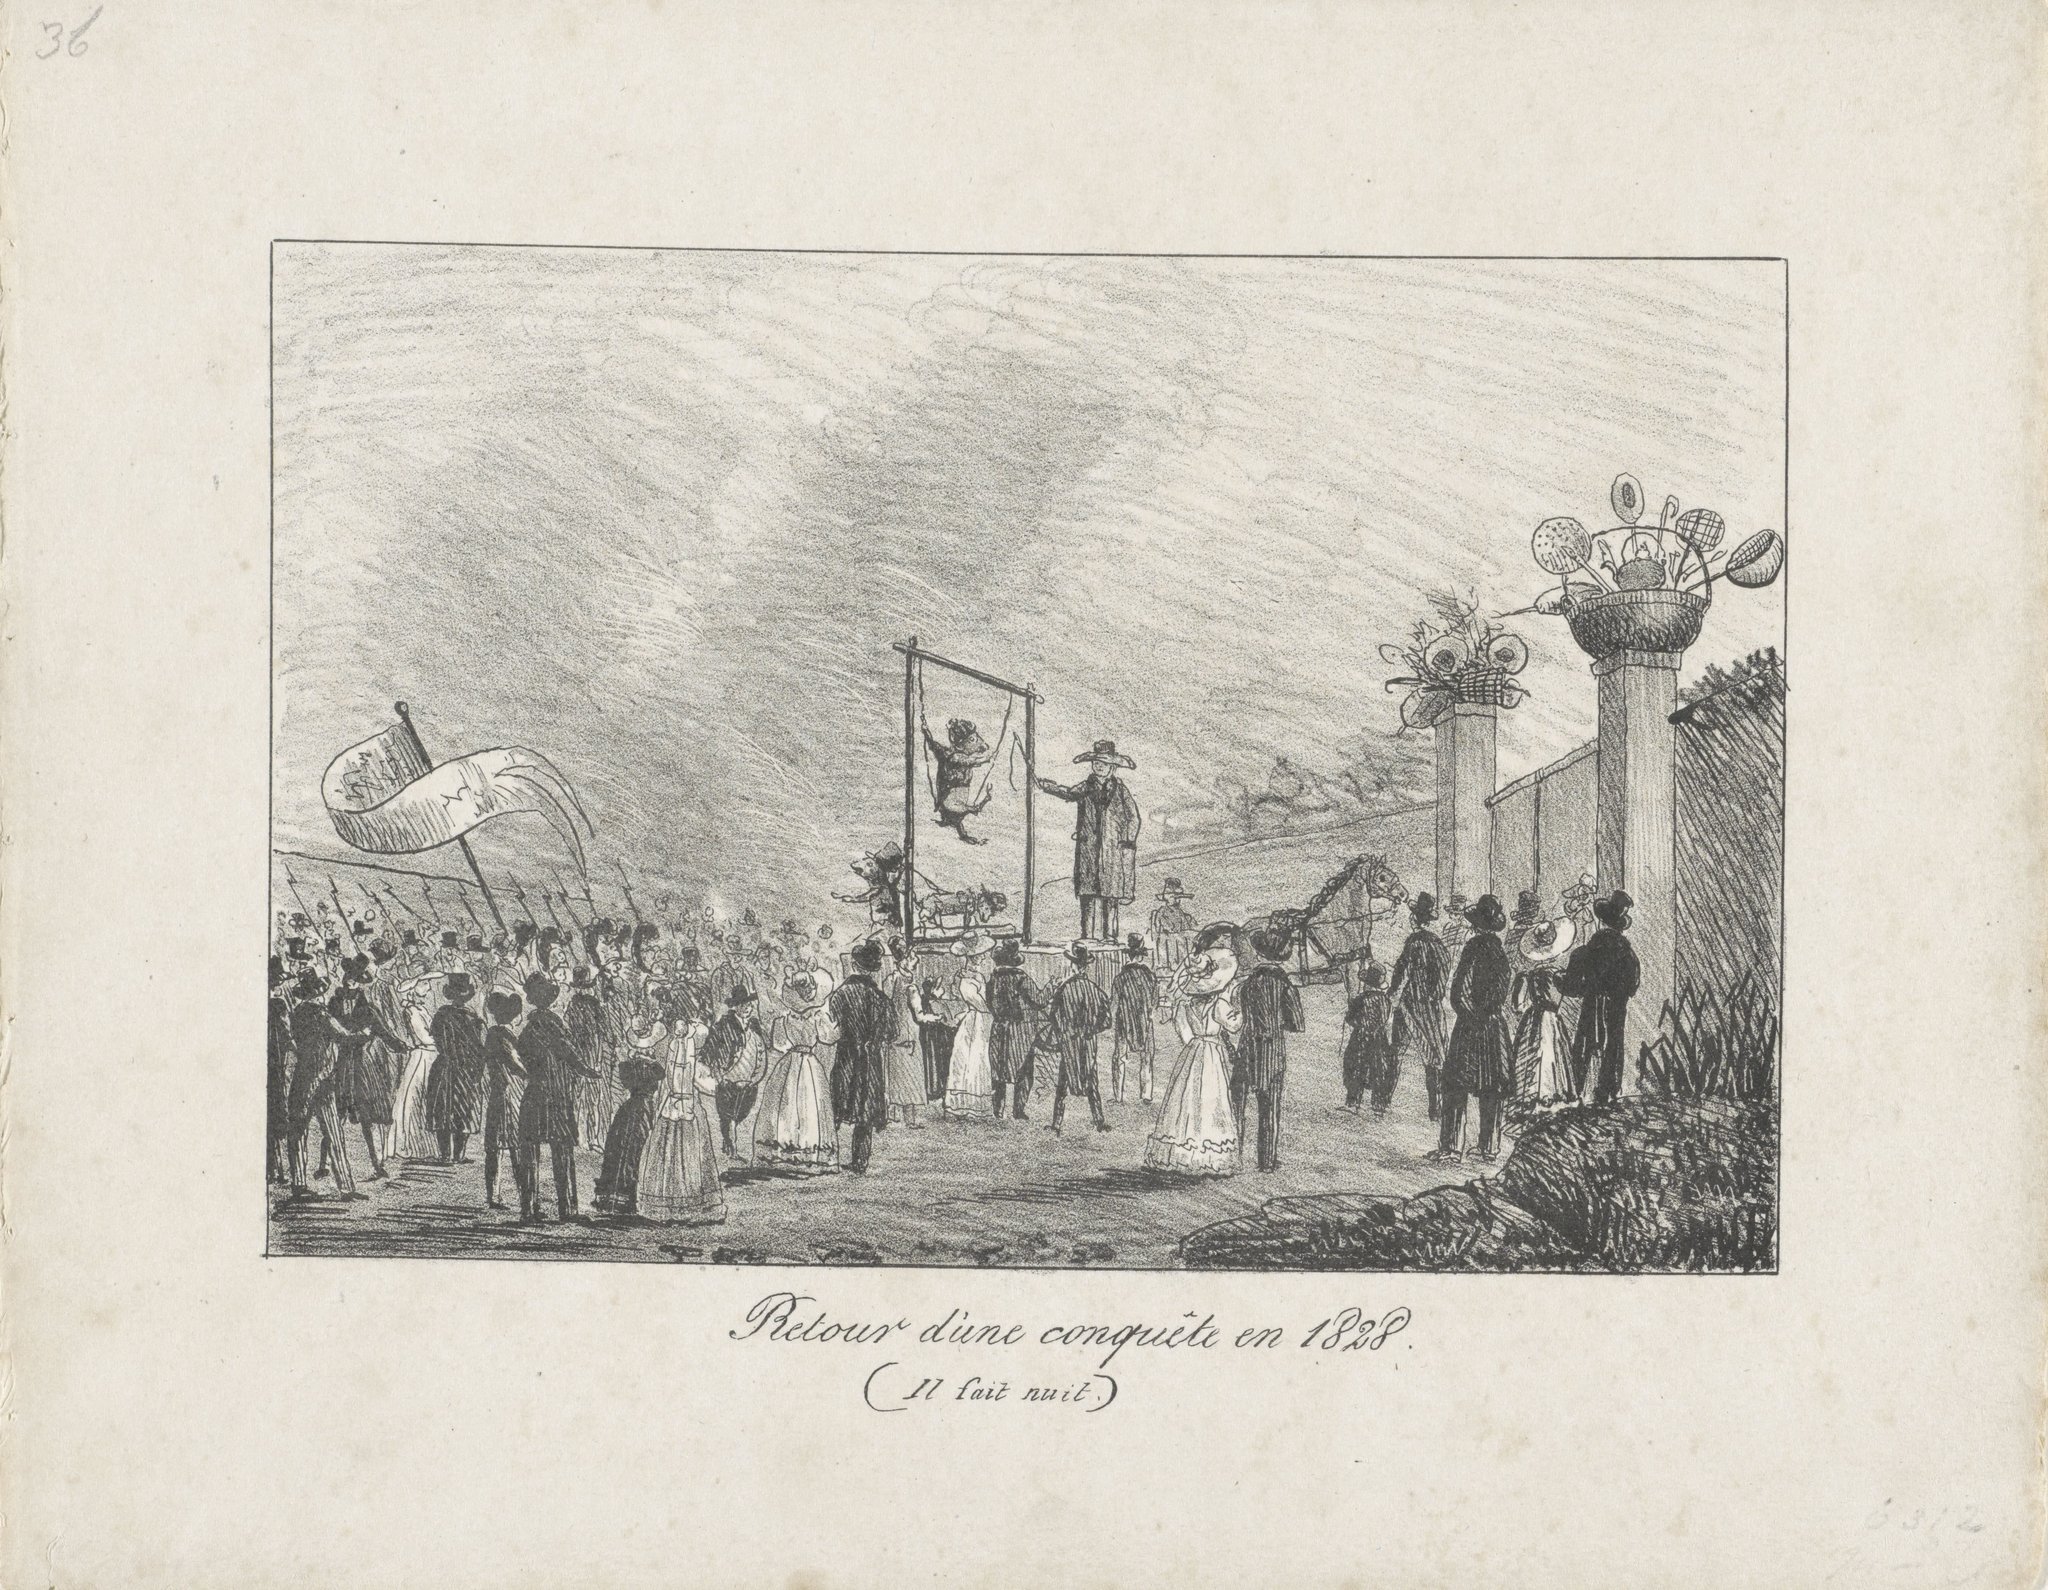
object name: cartoon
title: Retour d'une conquête en 1828 (Il fait nuit.)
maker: Anonymous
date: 1828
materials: paper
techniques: lithograph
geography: southern netherlands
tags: dogs (circus performance)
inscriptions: collector's mark: Lugt 2228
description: Spotprent waarin verschillende gedresseerde dieren (honden?) hun kunsten laten zien op een kar ten overstaan van een publiek en een groep soldaten met een vaandel. Rechts een afgesloten poort, de posten waarvan versierd zijn met ketels met keukenraad. Spotprent op een onbekende Brusselse gebeurtenis.